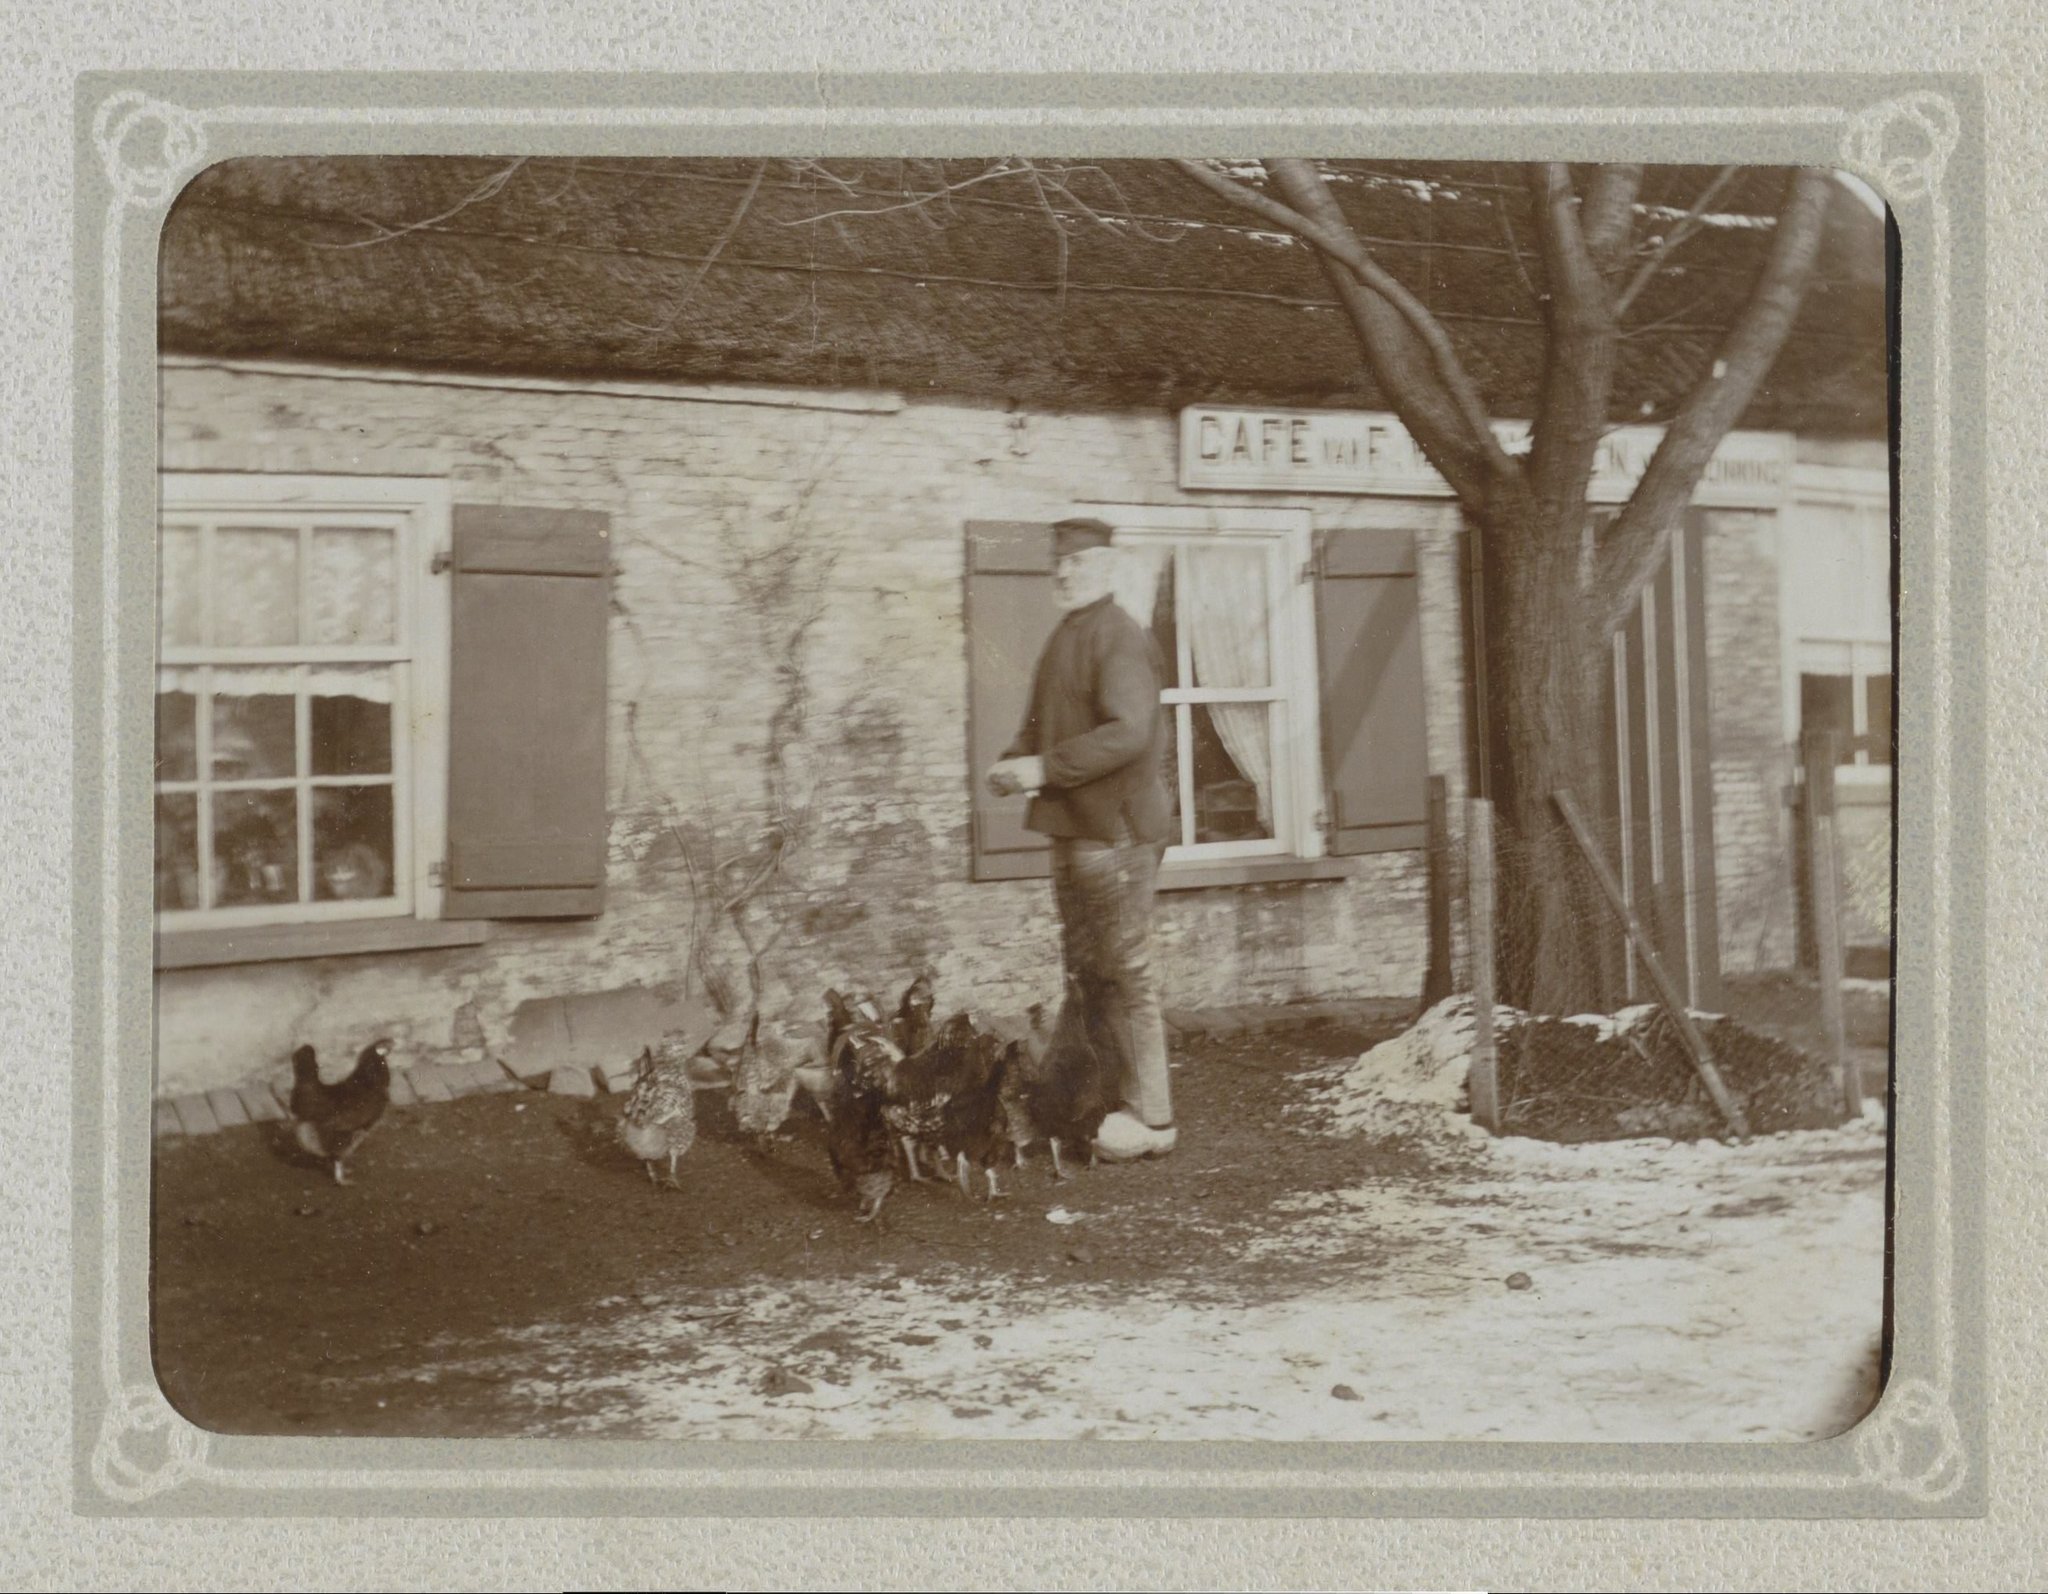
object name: photograph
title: Man voert kippen voor een café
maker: folkert idzes de jong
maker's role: architect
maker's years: 1877-1929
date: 1905-1907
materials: photographic support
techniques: collodion silver print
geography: netherlands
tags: wooden shoes, clogs, farmers, fowl (cock, hen, chicken, etc.), giving water, feeding (cattle), netherlands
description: Onderdeel van Topografisch album van Nederlandse dorpen en steden 1905.